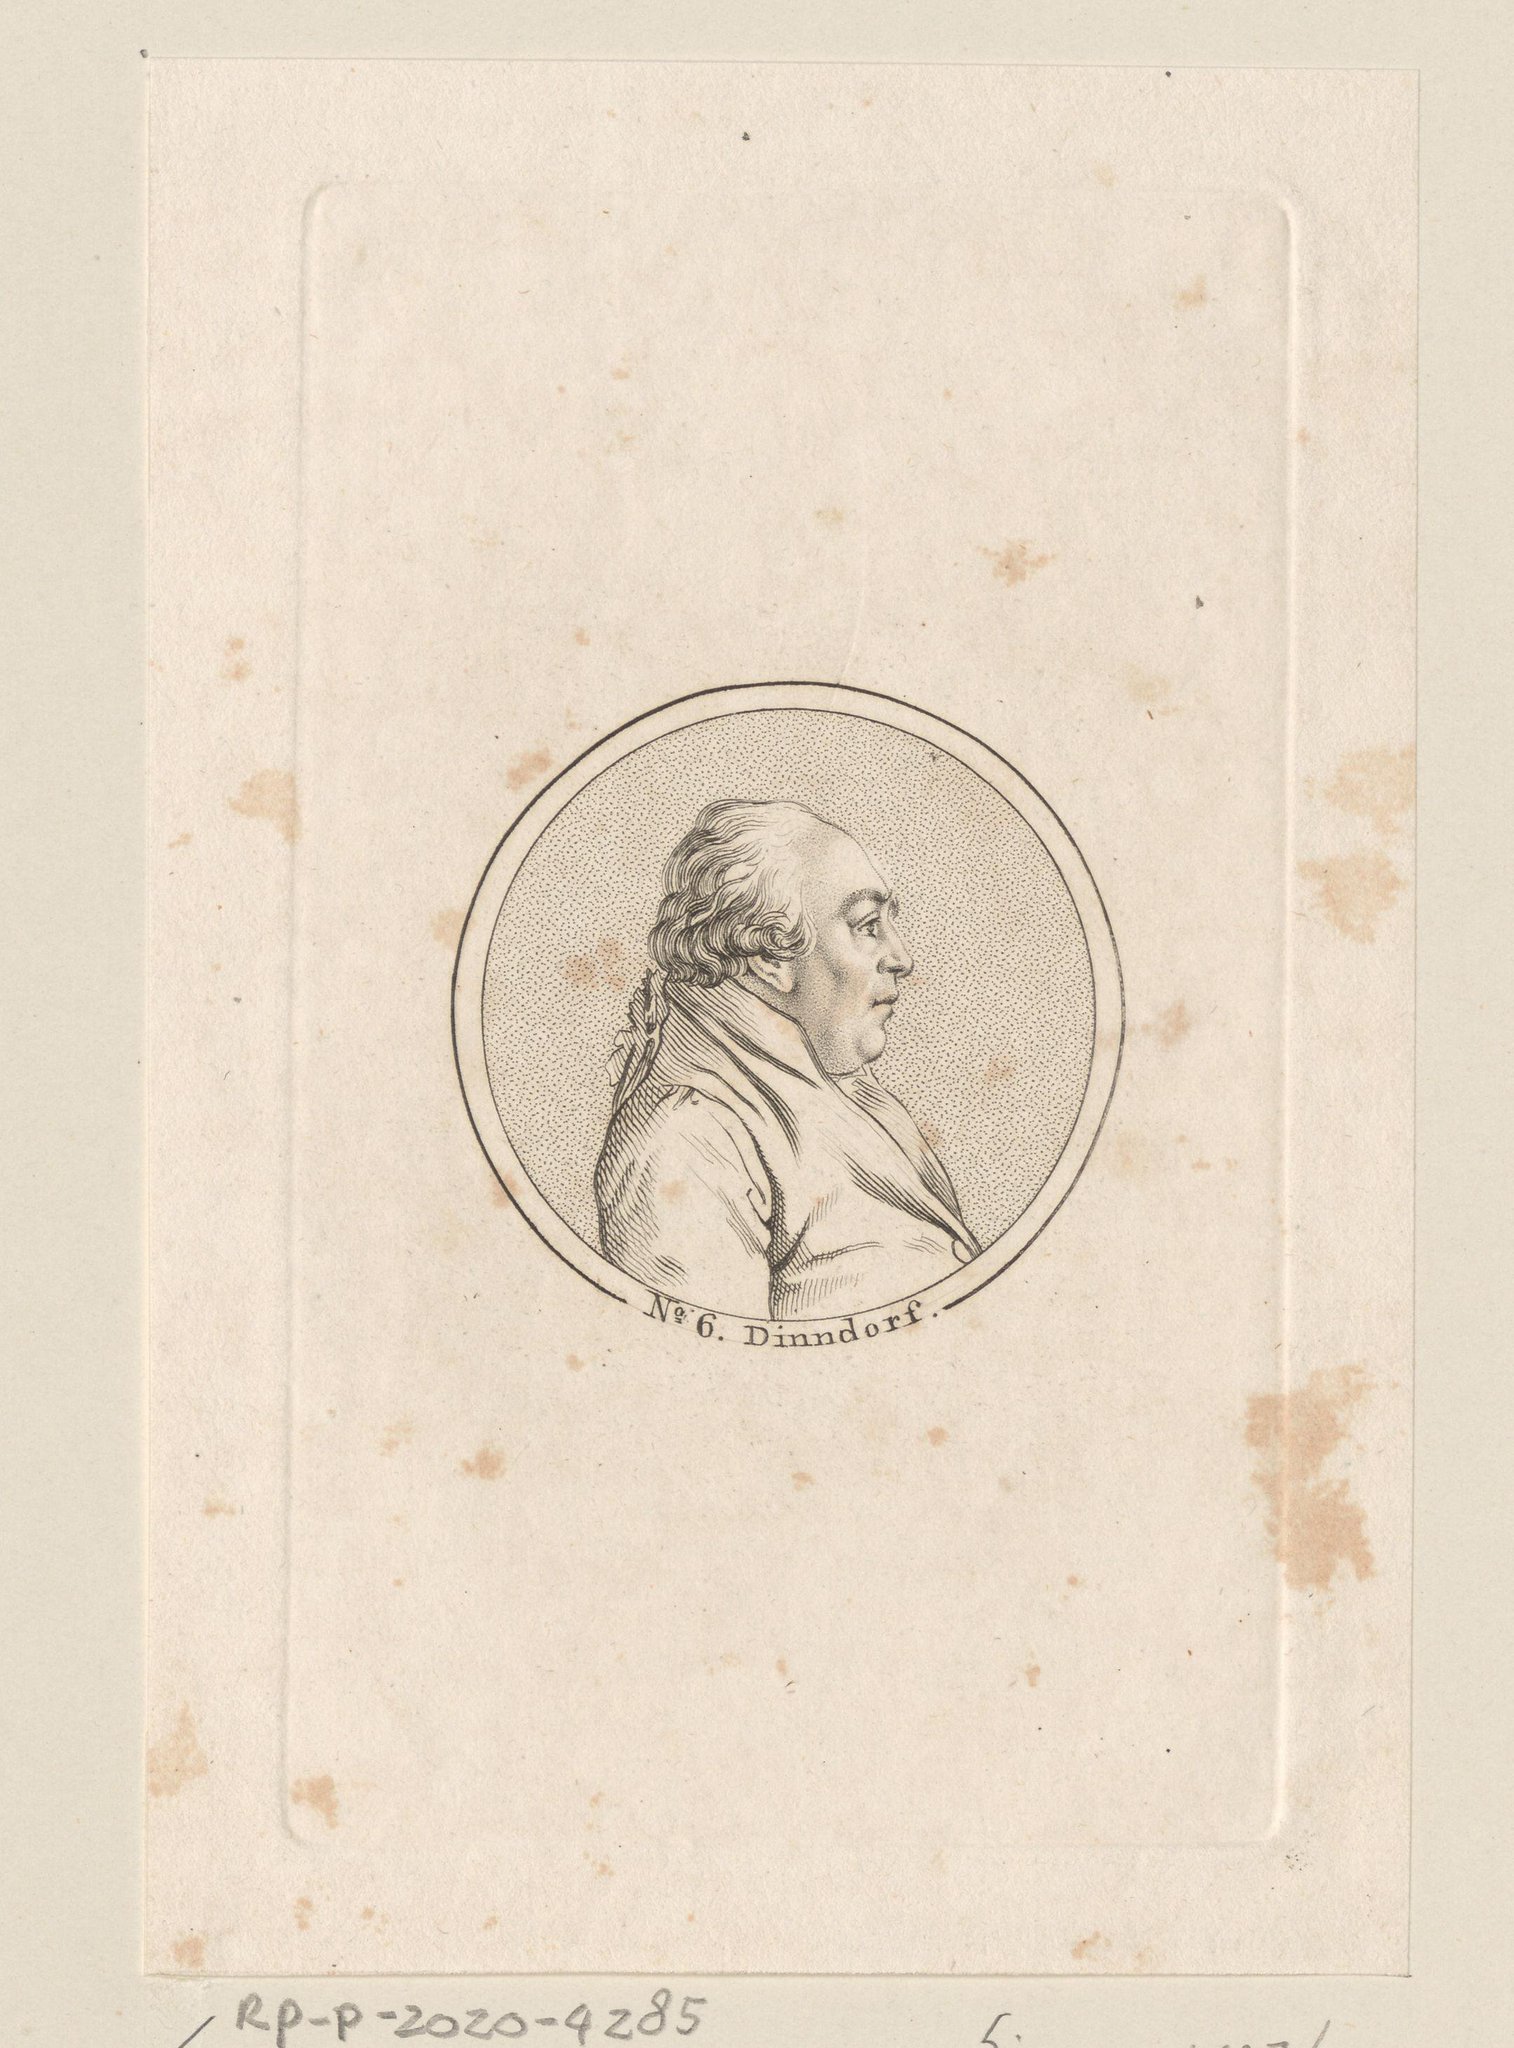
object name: print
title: Portret van Gottlieb Immanuel Dindorf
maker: wilhelm arndt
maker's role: print maker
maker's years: 1750-1813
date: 1810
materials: paper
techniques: etching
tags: theologian, historical persons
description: Prent waarschijnlijk uit: Kreussler, Heinrich Gottlieb. Autobiographieen Leipziger Gelehrten. Leipzig: J.B. Fleischer, 1810.